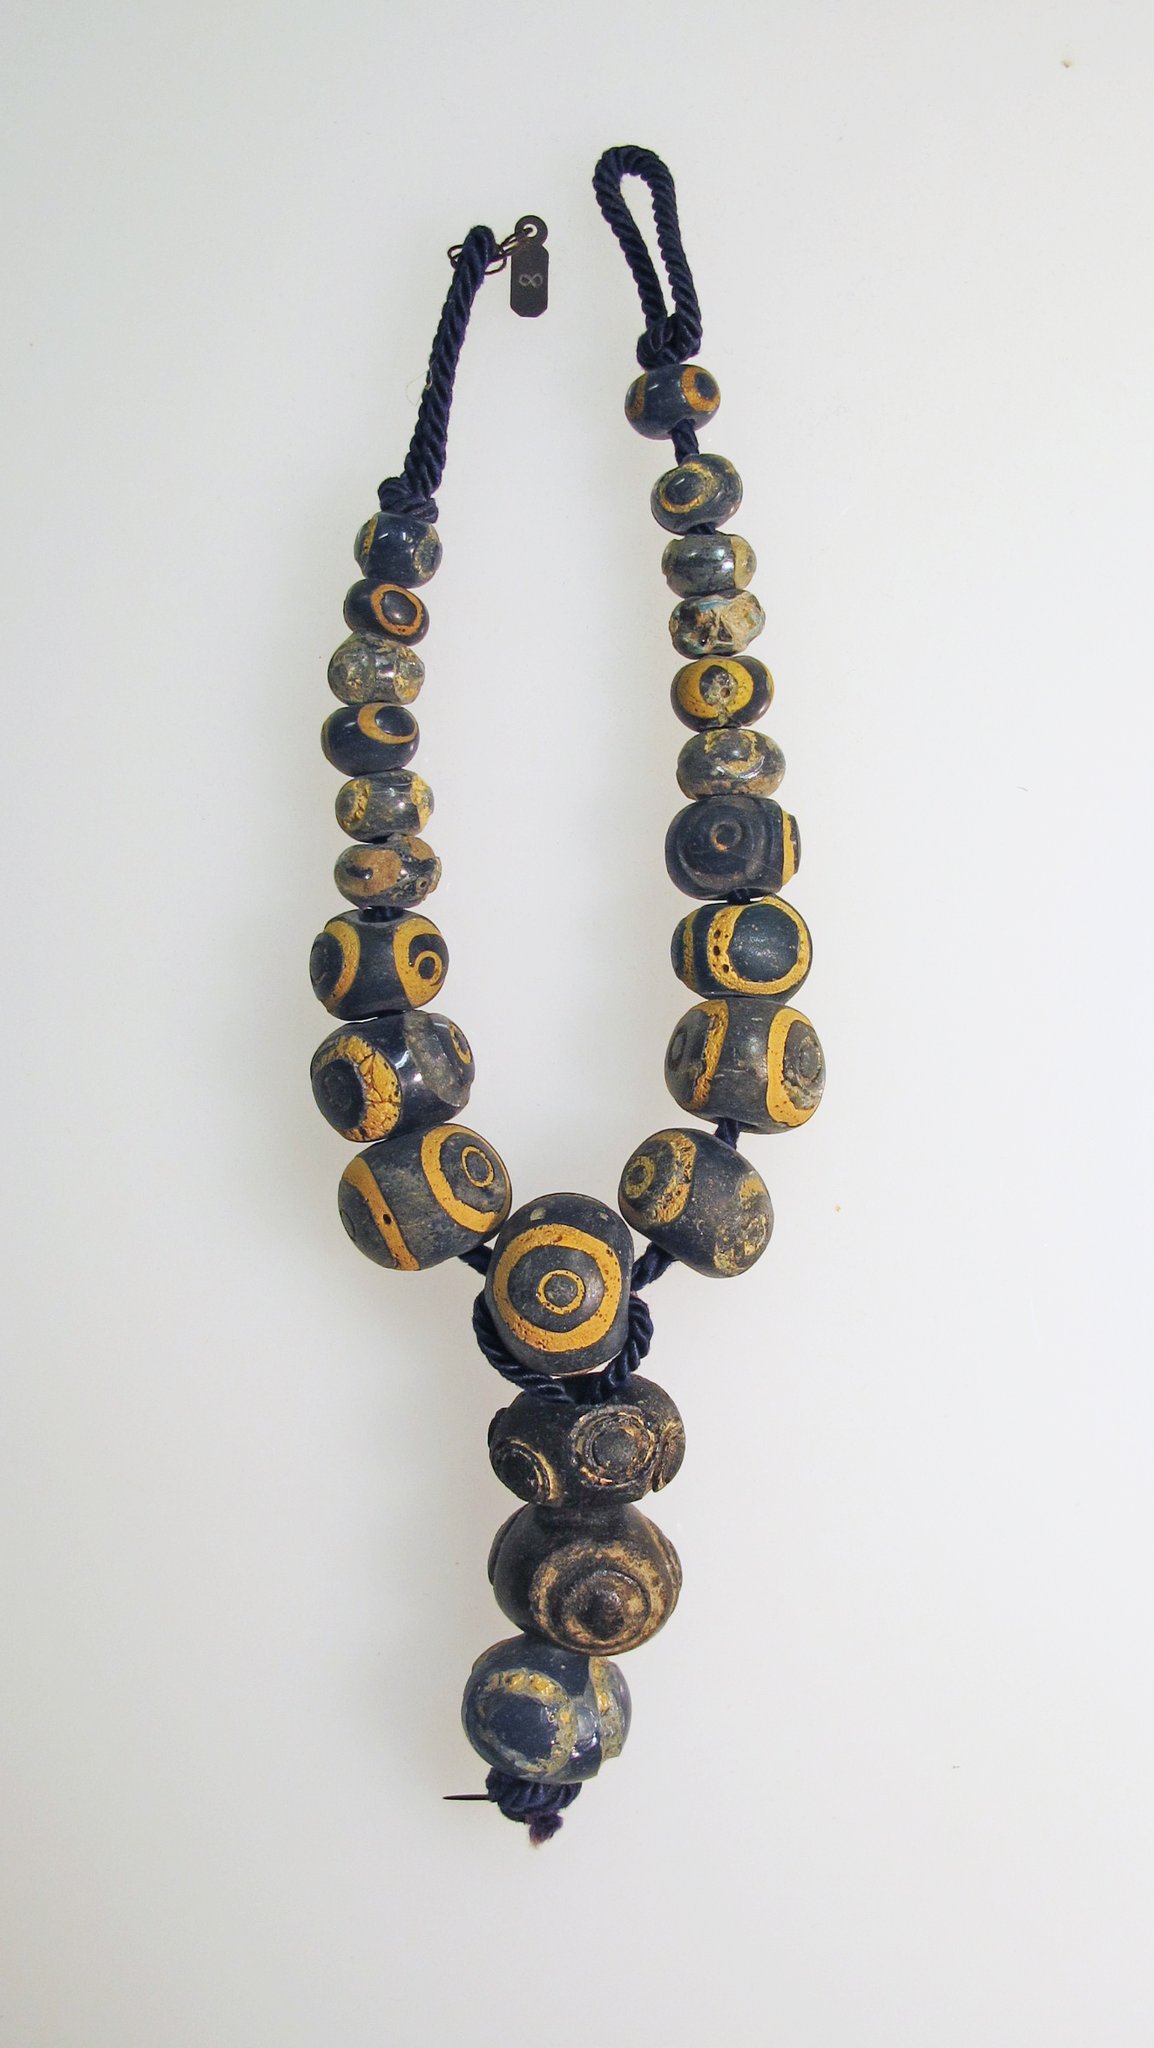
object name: bead, 23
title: Beads, 23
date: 7000 BCE-330 CE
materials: glass